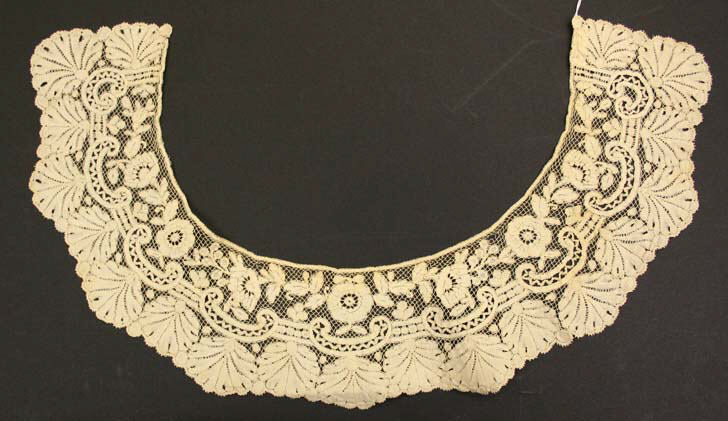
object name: collar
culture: french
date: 1850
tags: flowers